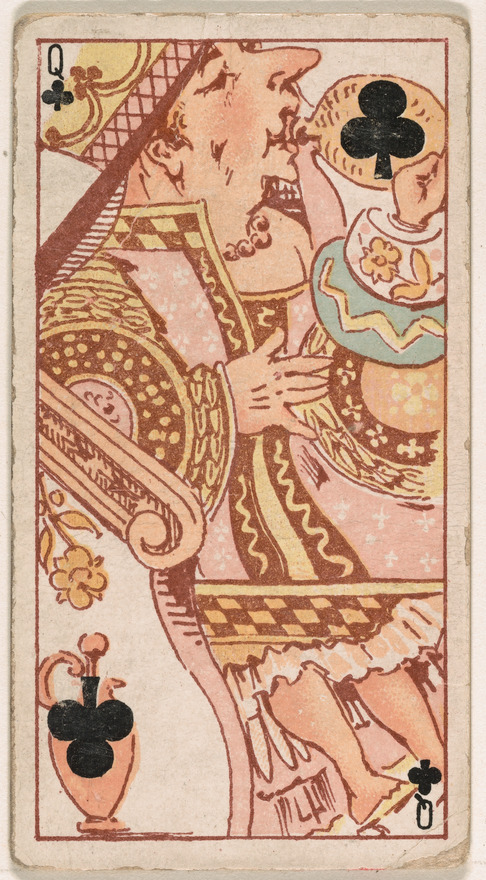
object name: print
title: Queen of Clubs, from Harlequin Cards, 2nd Series (N220) issued by Kinney Bros.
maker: kinney brothers tobacco company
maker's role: publisher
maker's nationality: american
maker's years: 1869-2011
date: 1889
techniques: color lithograph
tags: queens,playing cards